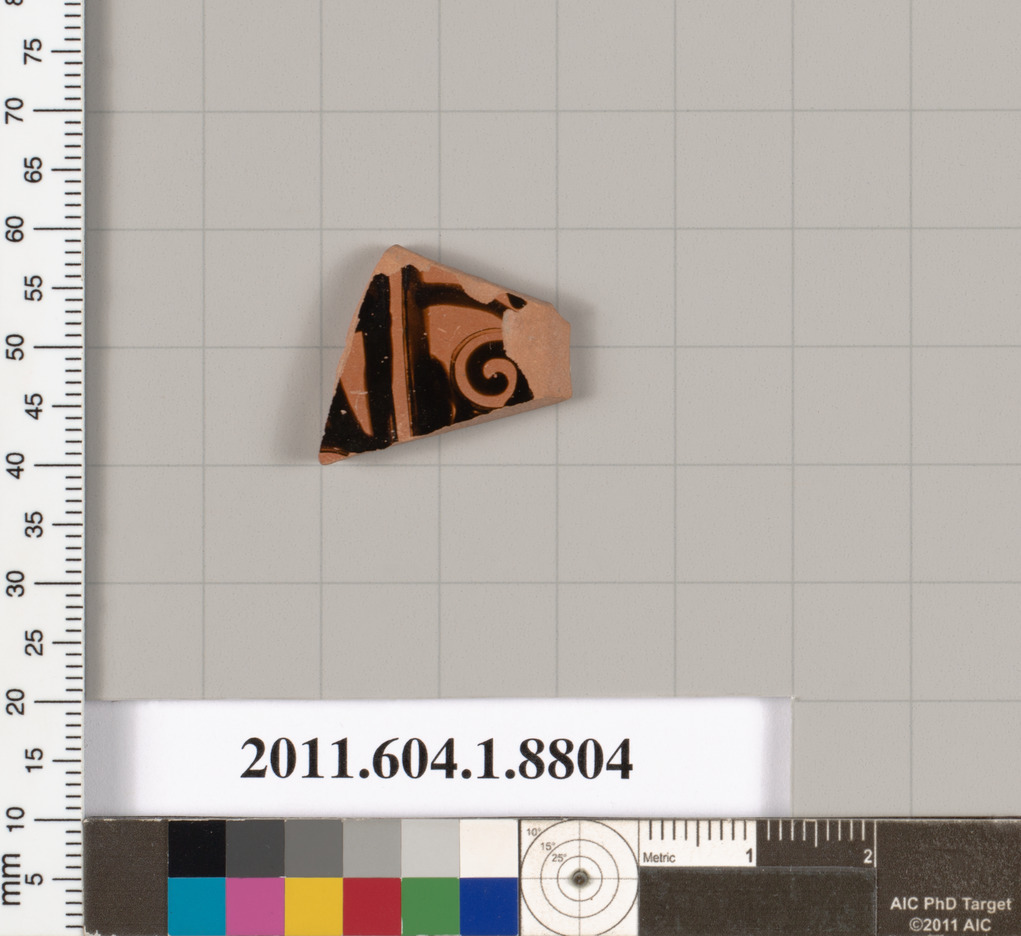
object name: kylix fragment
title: Terracotta fragment of a kylix (drinking cup)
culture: greek, attic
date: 490-480 BCE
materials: terracotta